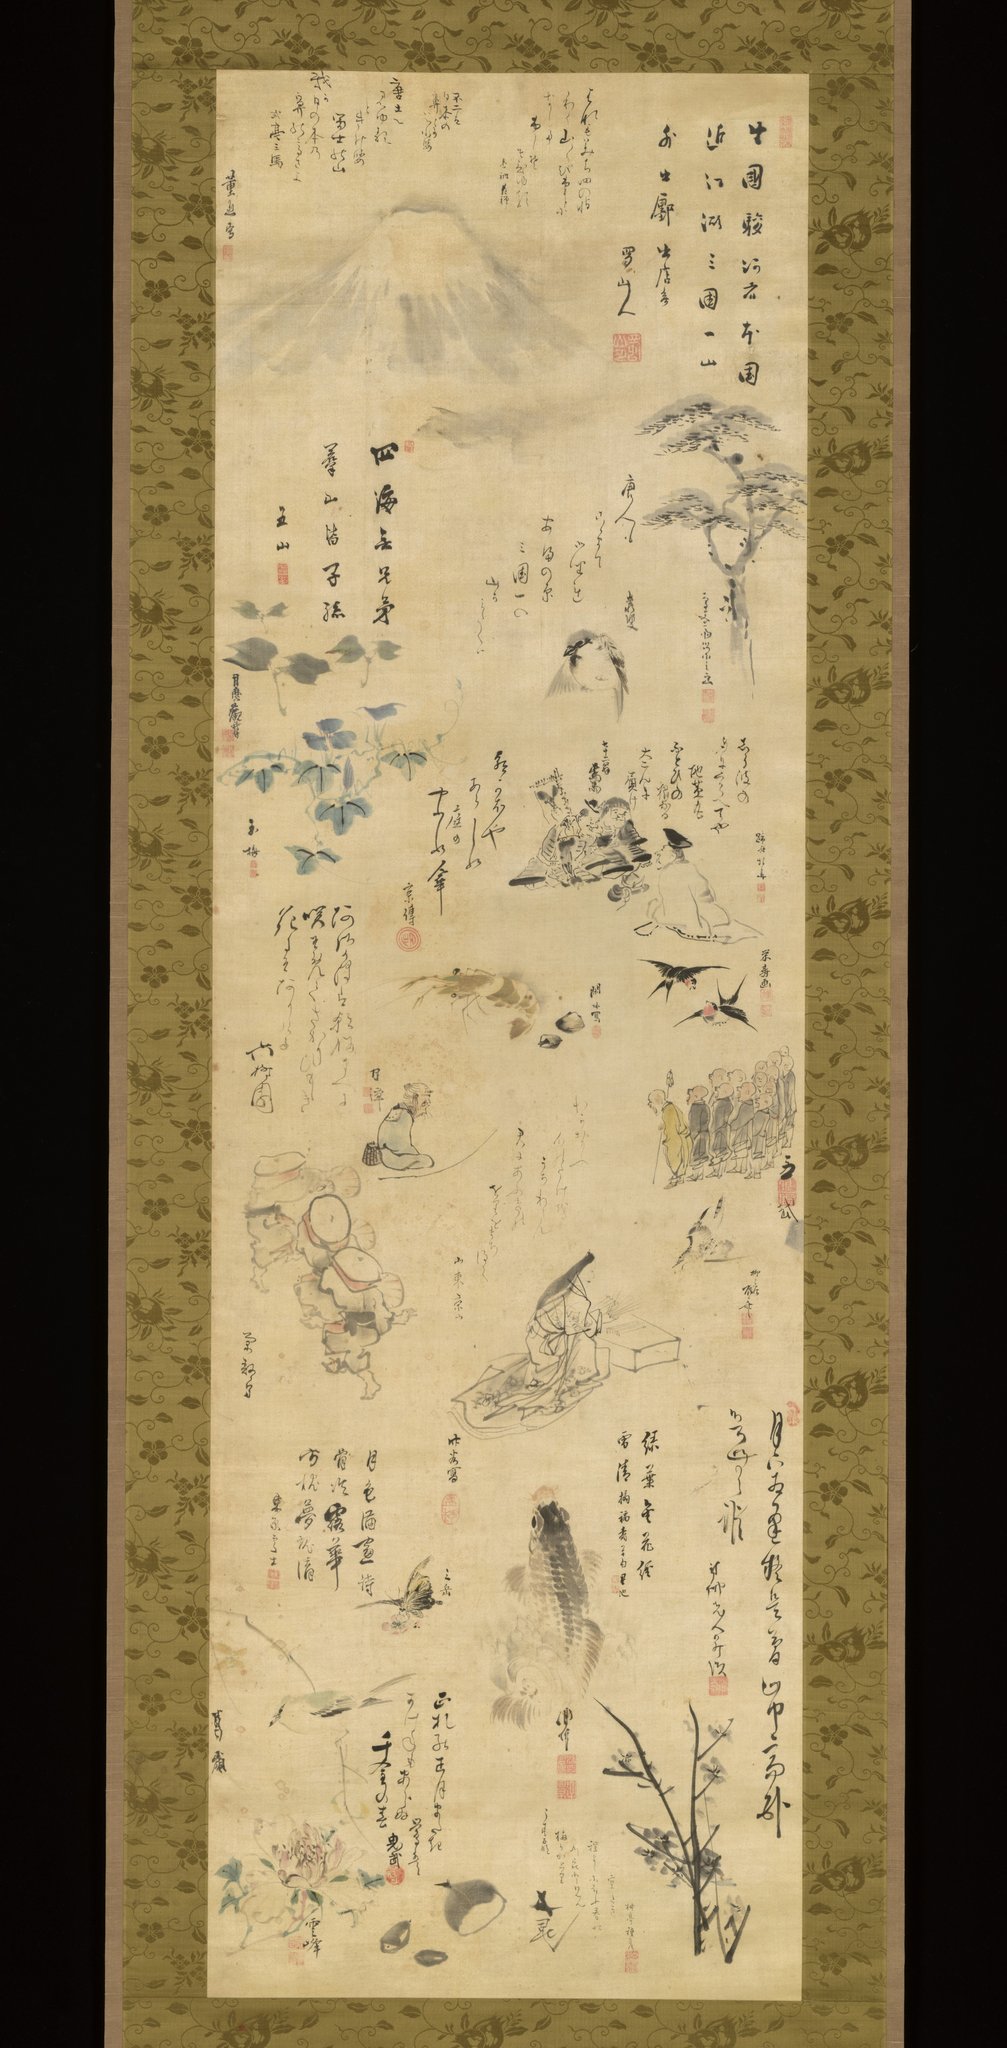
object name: hanging scroll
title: Drawings and Poems by Various Artists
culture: japanese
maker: shokusanjin (ōta nanpo)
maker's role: artist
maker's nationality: japanese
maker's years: 1749-1823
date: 1814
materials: ink, silk